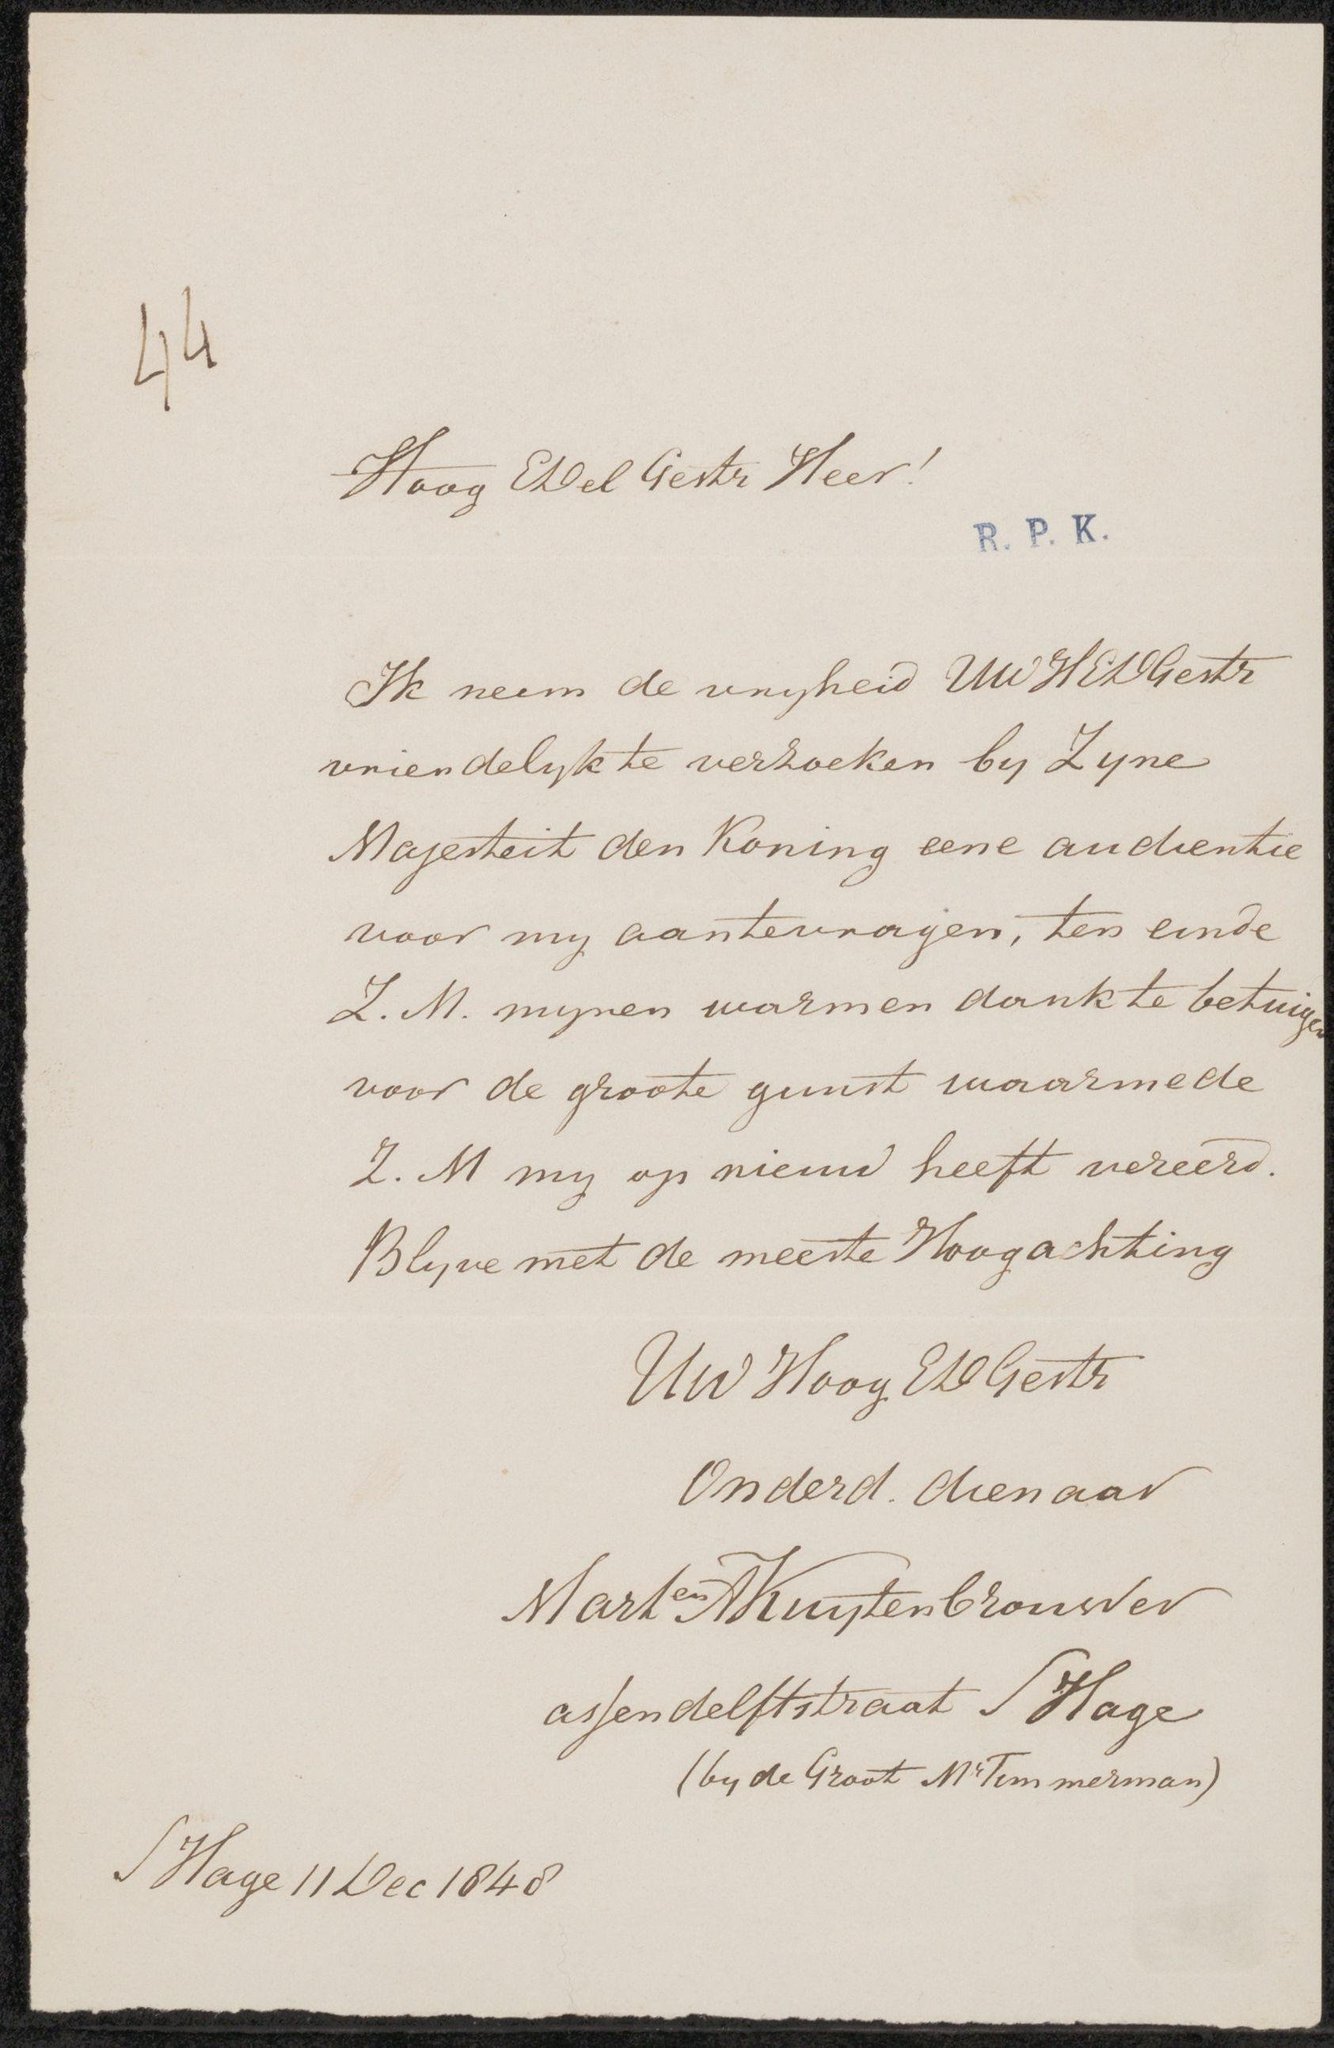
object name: letter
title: Brief aan anoniem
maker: martinus antonius kuytenbrouwer (i)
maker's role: amateurschilder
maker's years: 1777-1850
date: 1848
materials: ink, paper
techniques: pen, writing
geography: the hague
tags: william ii of the netherlands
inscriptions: collector's mark: Lugt 2233